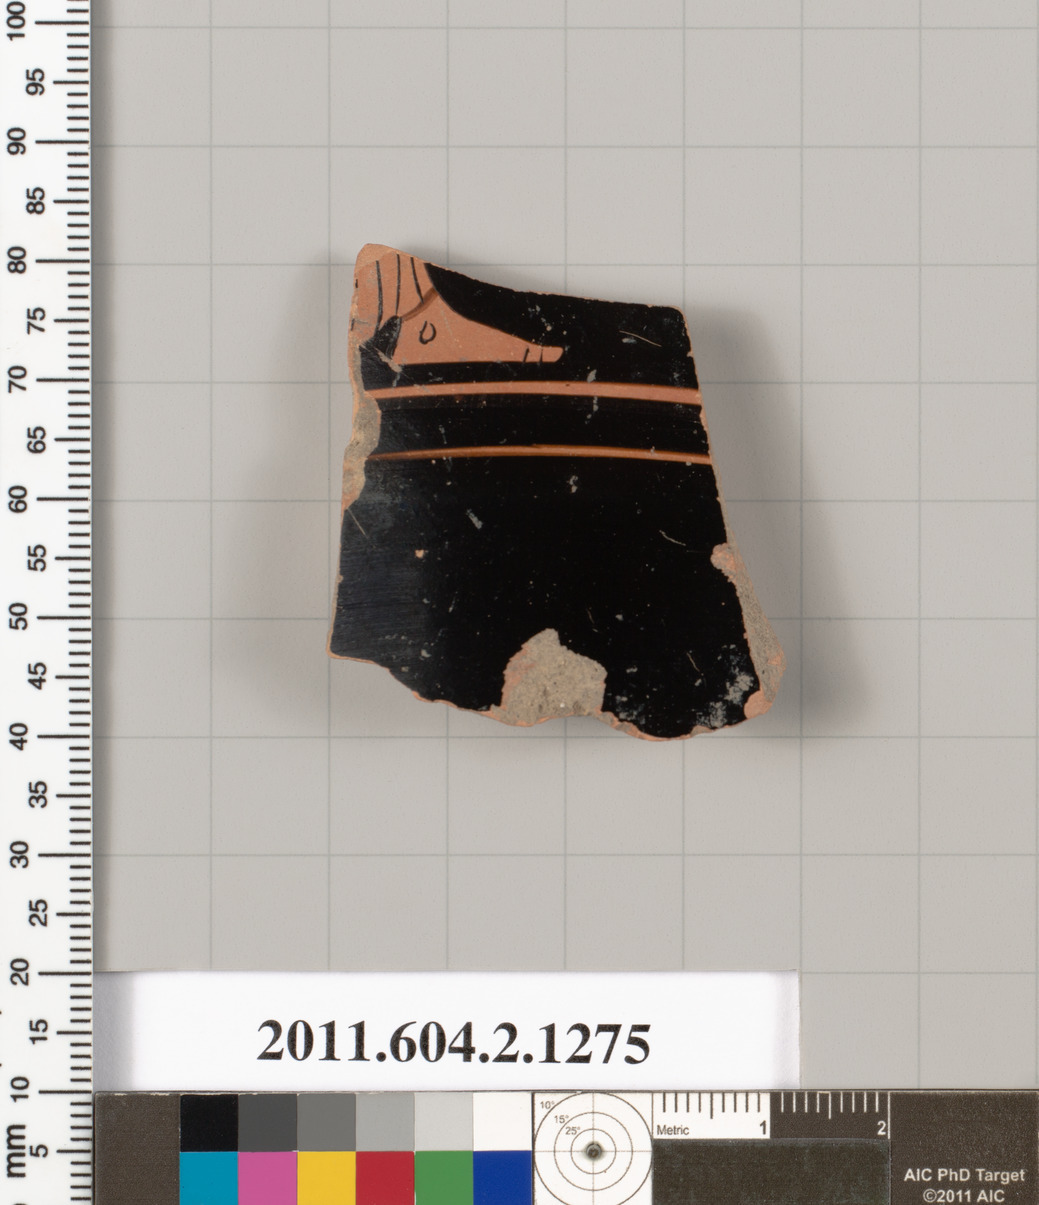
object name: skyphos fragment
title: Terracotta fragment of a skyphos (deep drinking cup)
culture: greek, attic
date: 460-440 BCE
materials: terracotta